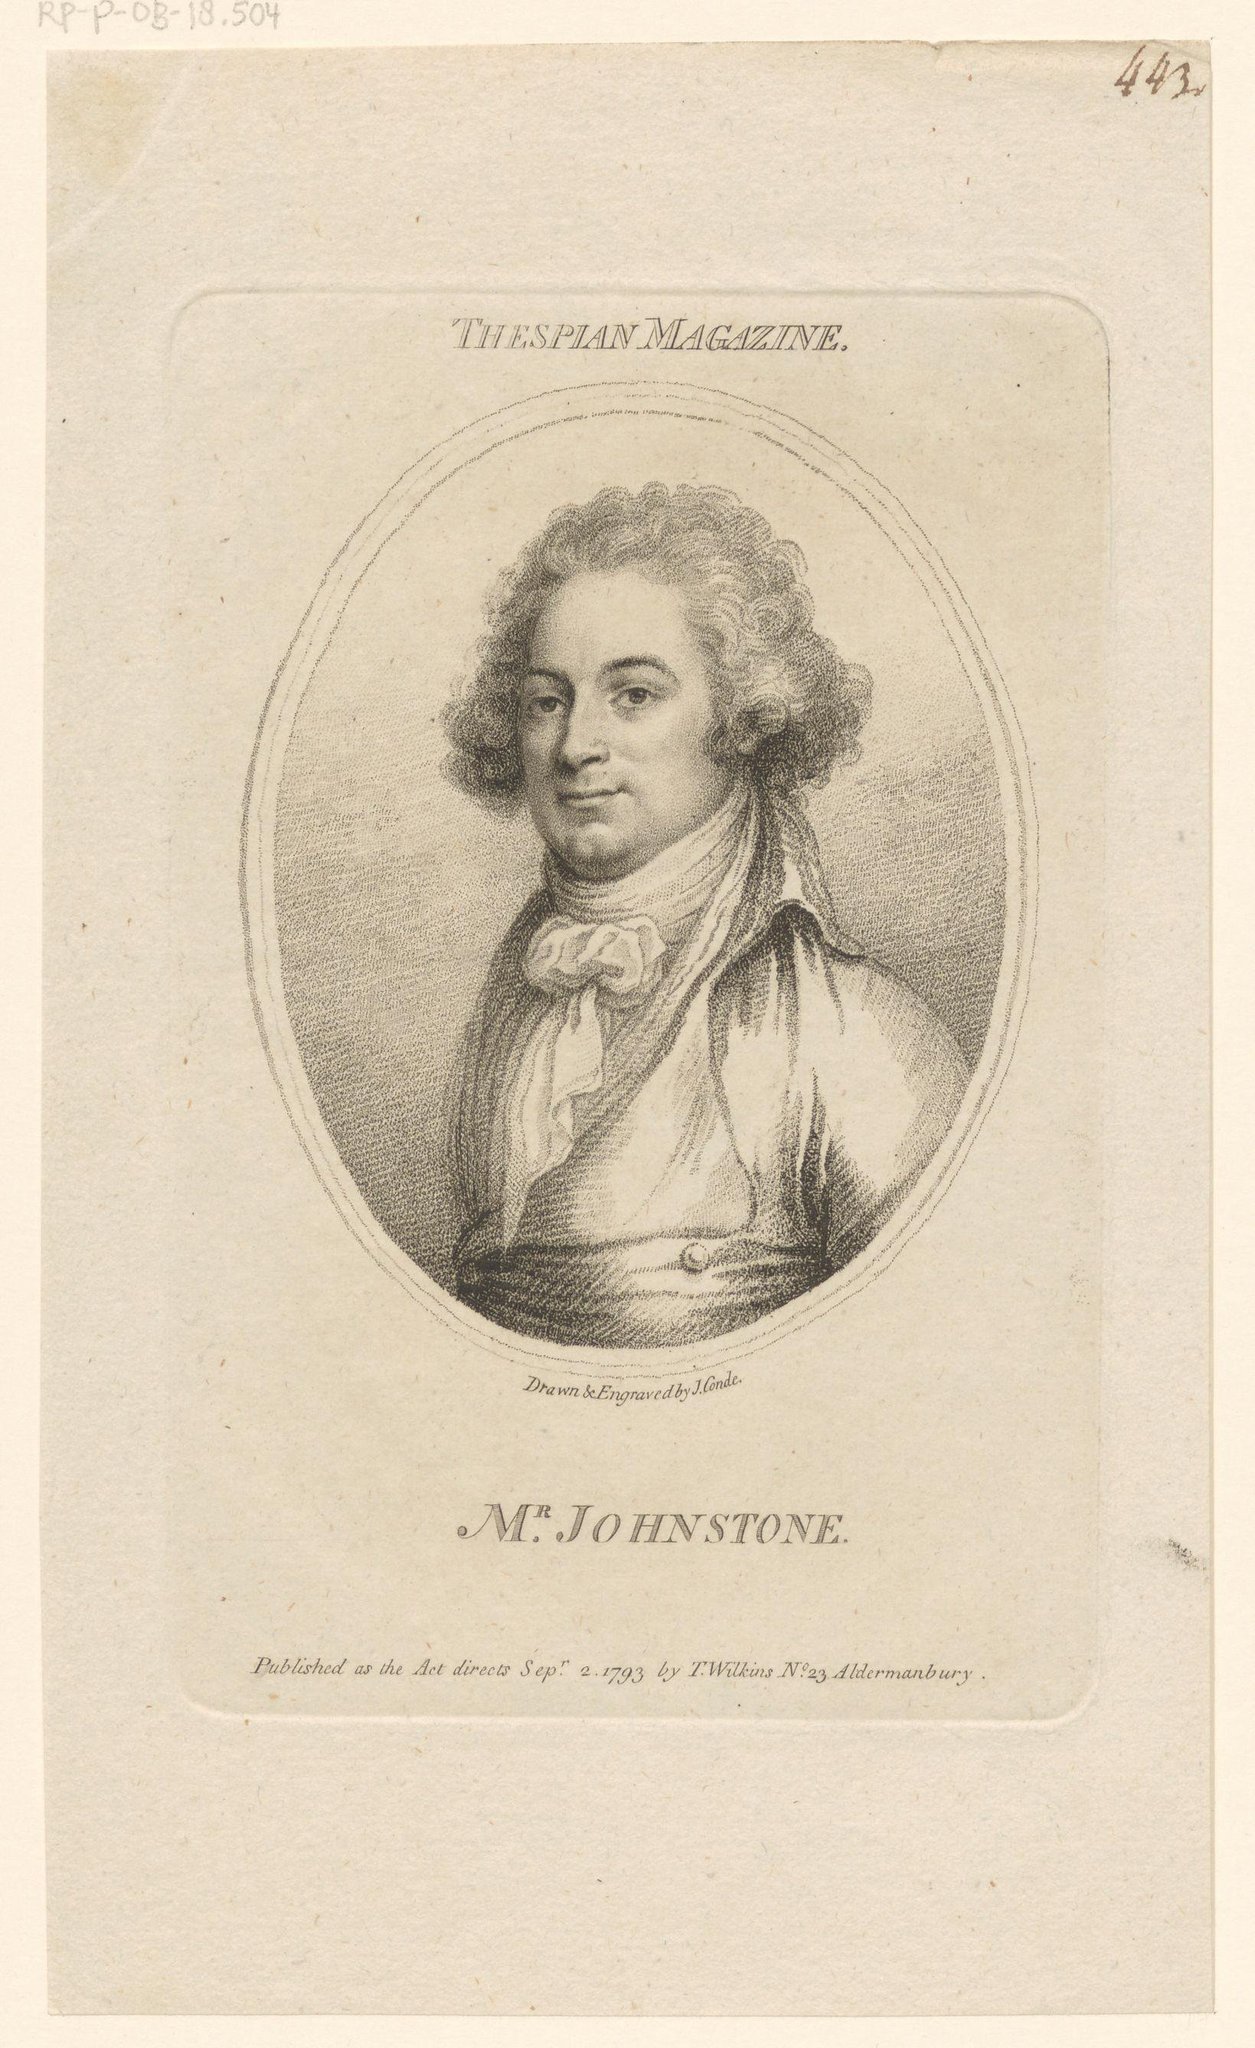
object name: print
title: Portret van John Henry Johnstone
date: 1793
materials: paper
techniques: stippling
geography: aldermanbury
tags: historical persons, portrait of actor, actress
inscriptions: collector's mark: Lugt 2228, number: ‘443’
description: Prent gebruikt in: Thespian Magazine (1793).